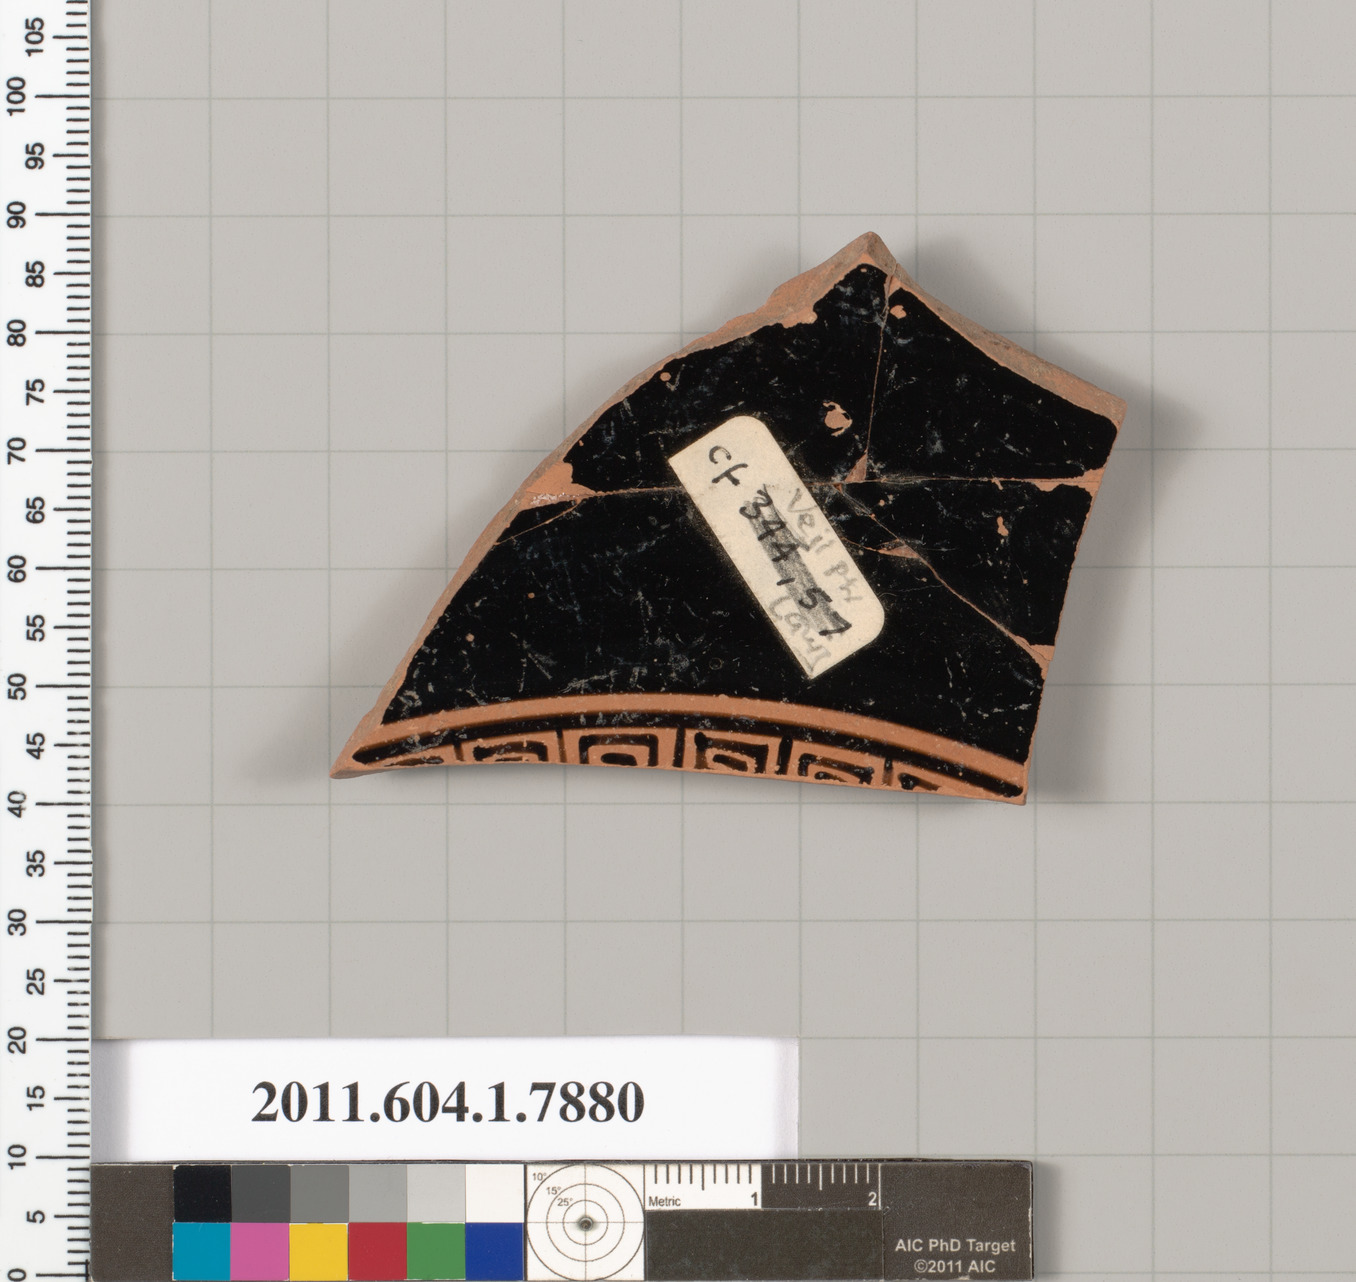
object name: kylix fragment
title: Terracotta fragment of a kylix (drinking cup)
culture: greek, attic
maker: veii painter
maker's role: artist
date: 460-450 BCE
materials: terracotta